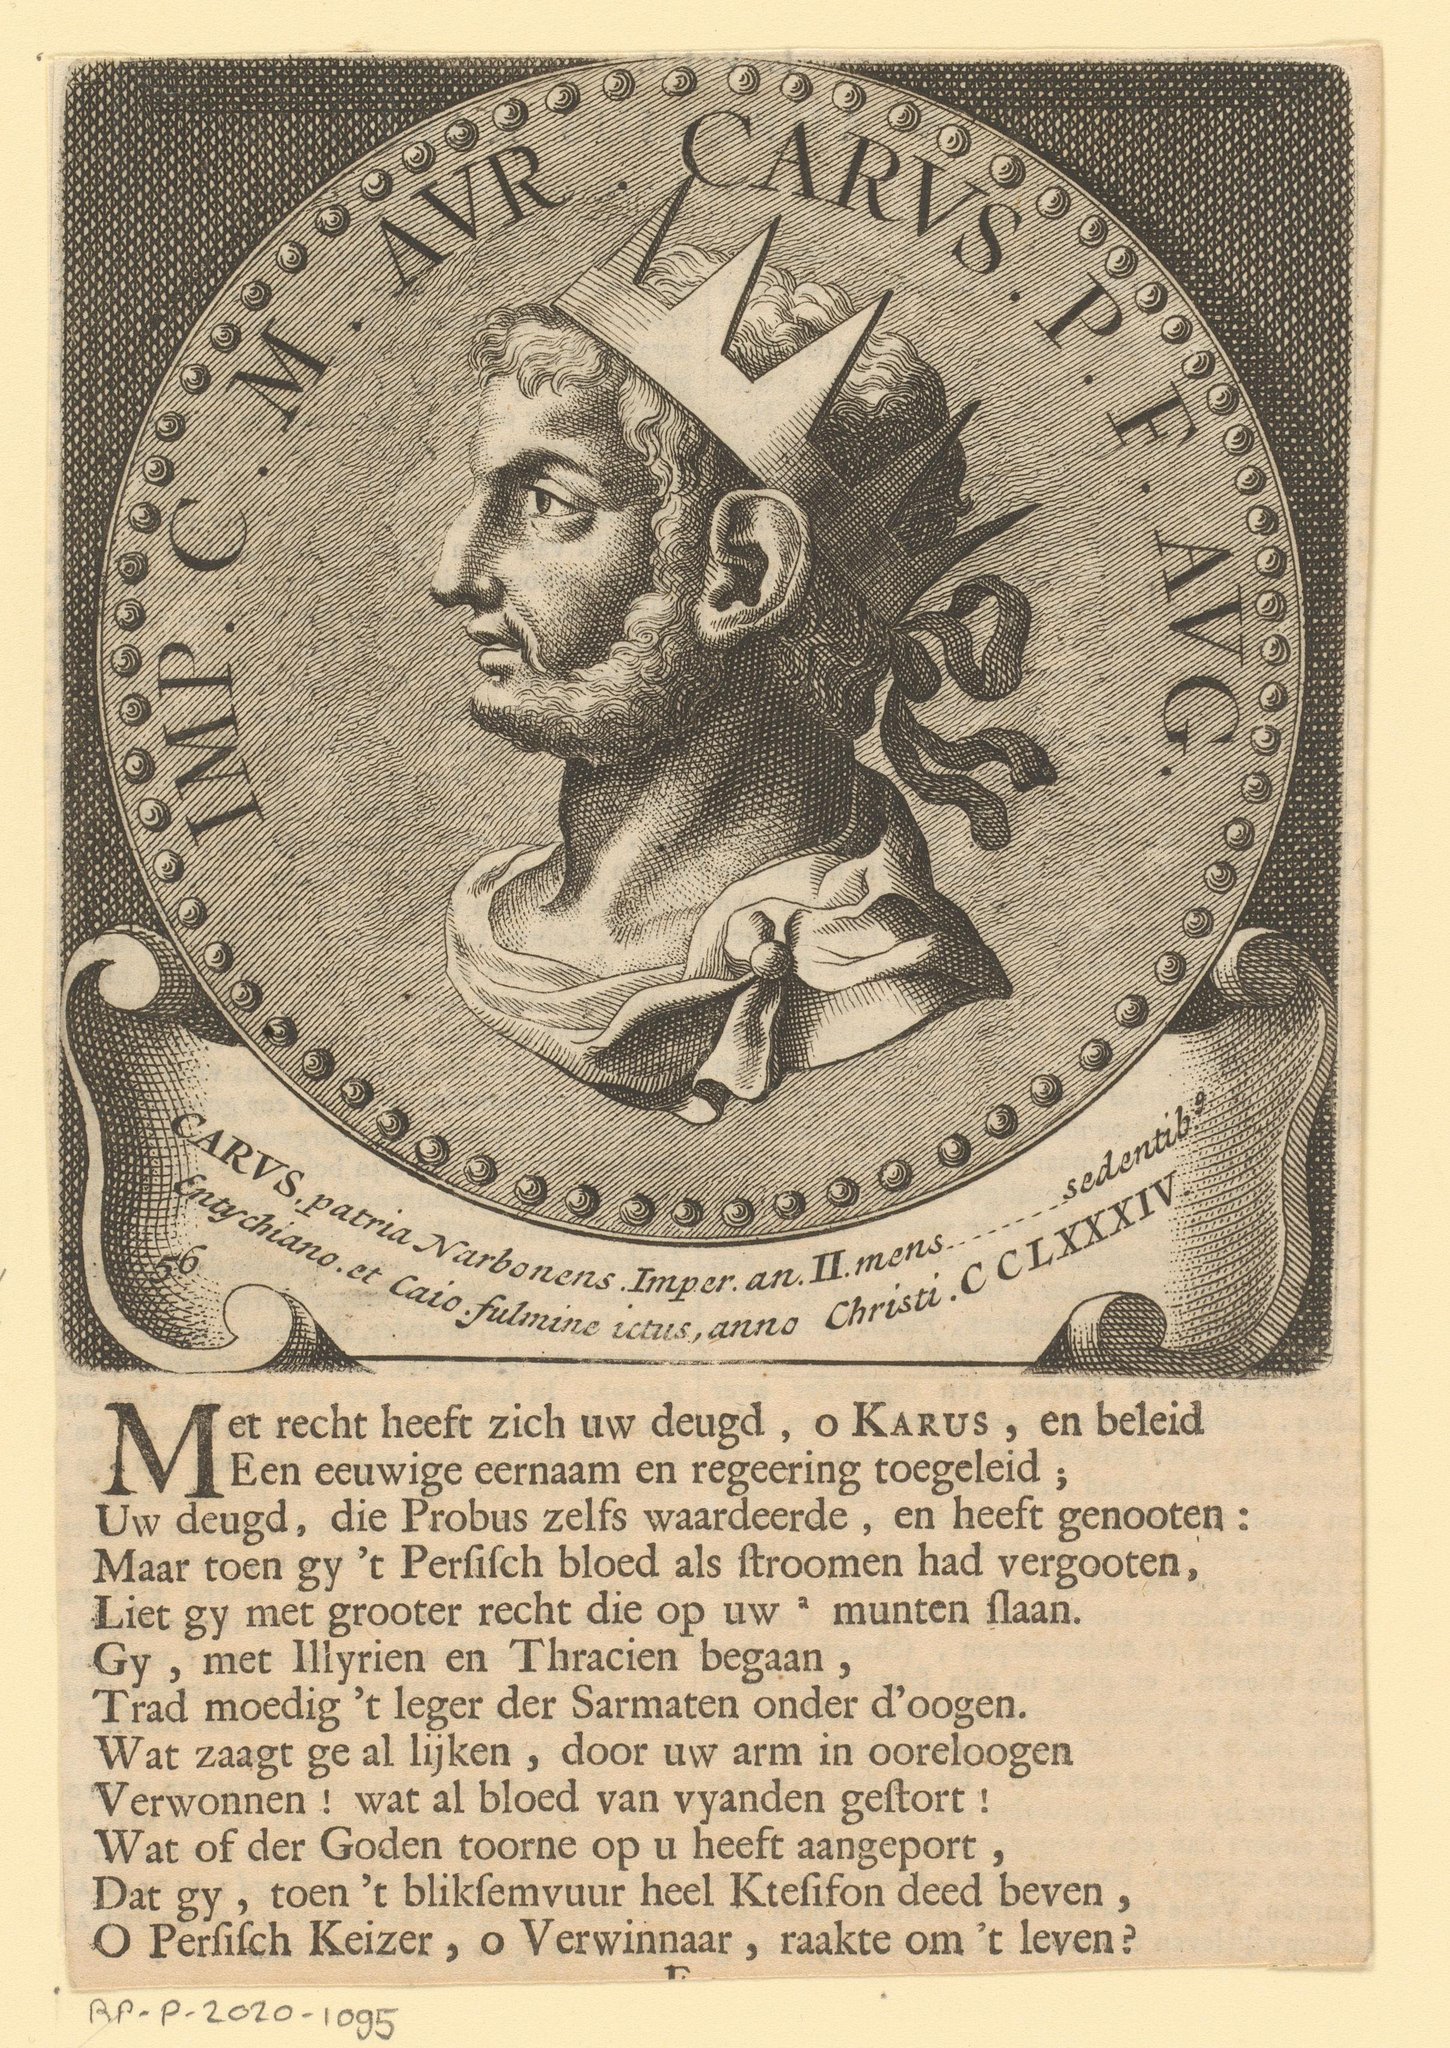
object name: print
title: Portret van keizer Carus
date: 1697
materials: paper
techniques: engraving, etching, letterpress printing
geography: utrecht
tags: historical persons, emperor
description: Prent uit: Bogaert, Abraham. De Roomsche monarchy, vertoont in de muntbeelden der westersche en oostersche keizeren (...). Utrecht: François Halma en Willem van de Water, 1697, p. 219. Eerste staat verschenen in een grotere prent met twaalf portretten, gedateerd 1695.